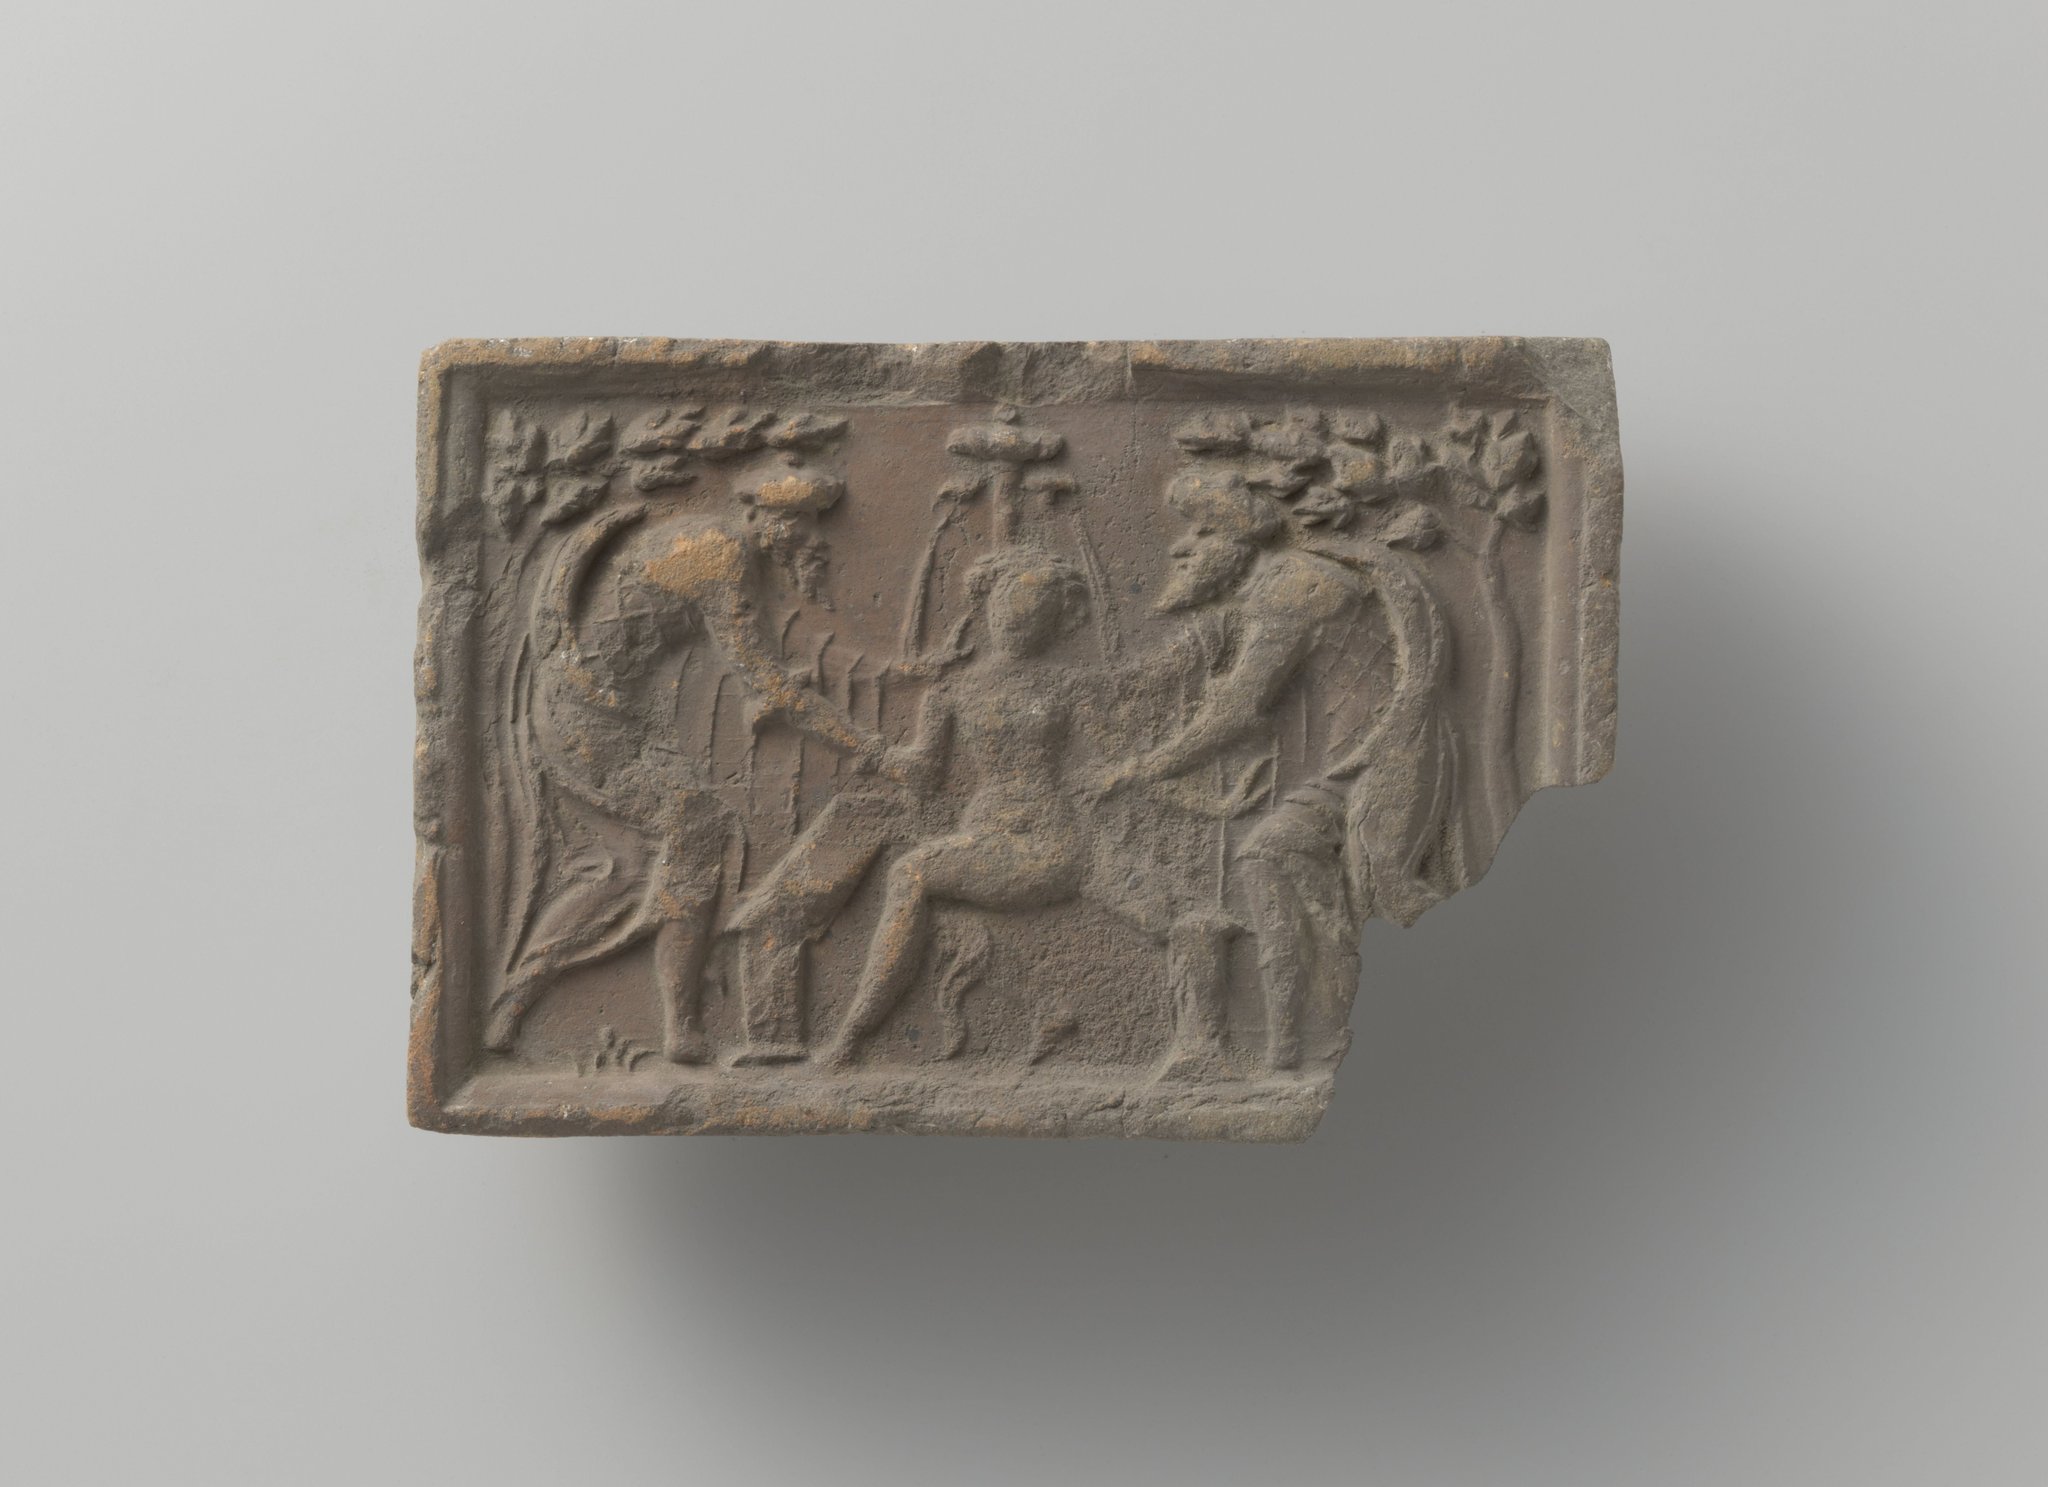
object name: architectural element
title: Haardsteen met een voorstelling van Susanna in het bad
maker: Anonymous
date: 1525-1575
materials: earthenware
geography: southern netherlands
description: haardsteen met een voorstelling van de badende Susanna, die wordt benaderd door de twee ouderlingen. Op de achtergrond een fontein en enkele bomen